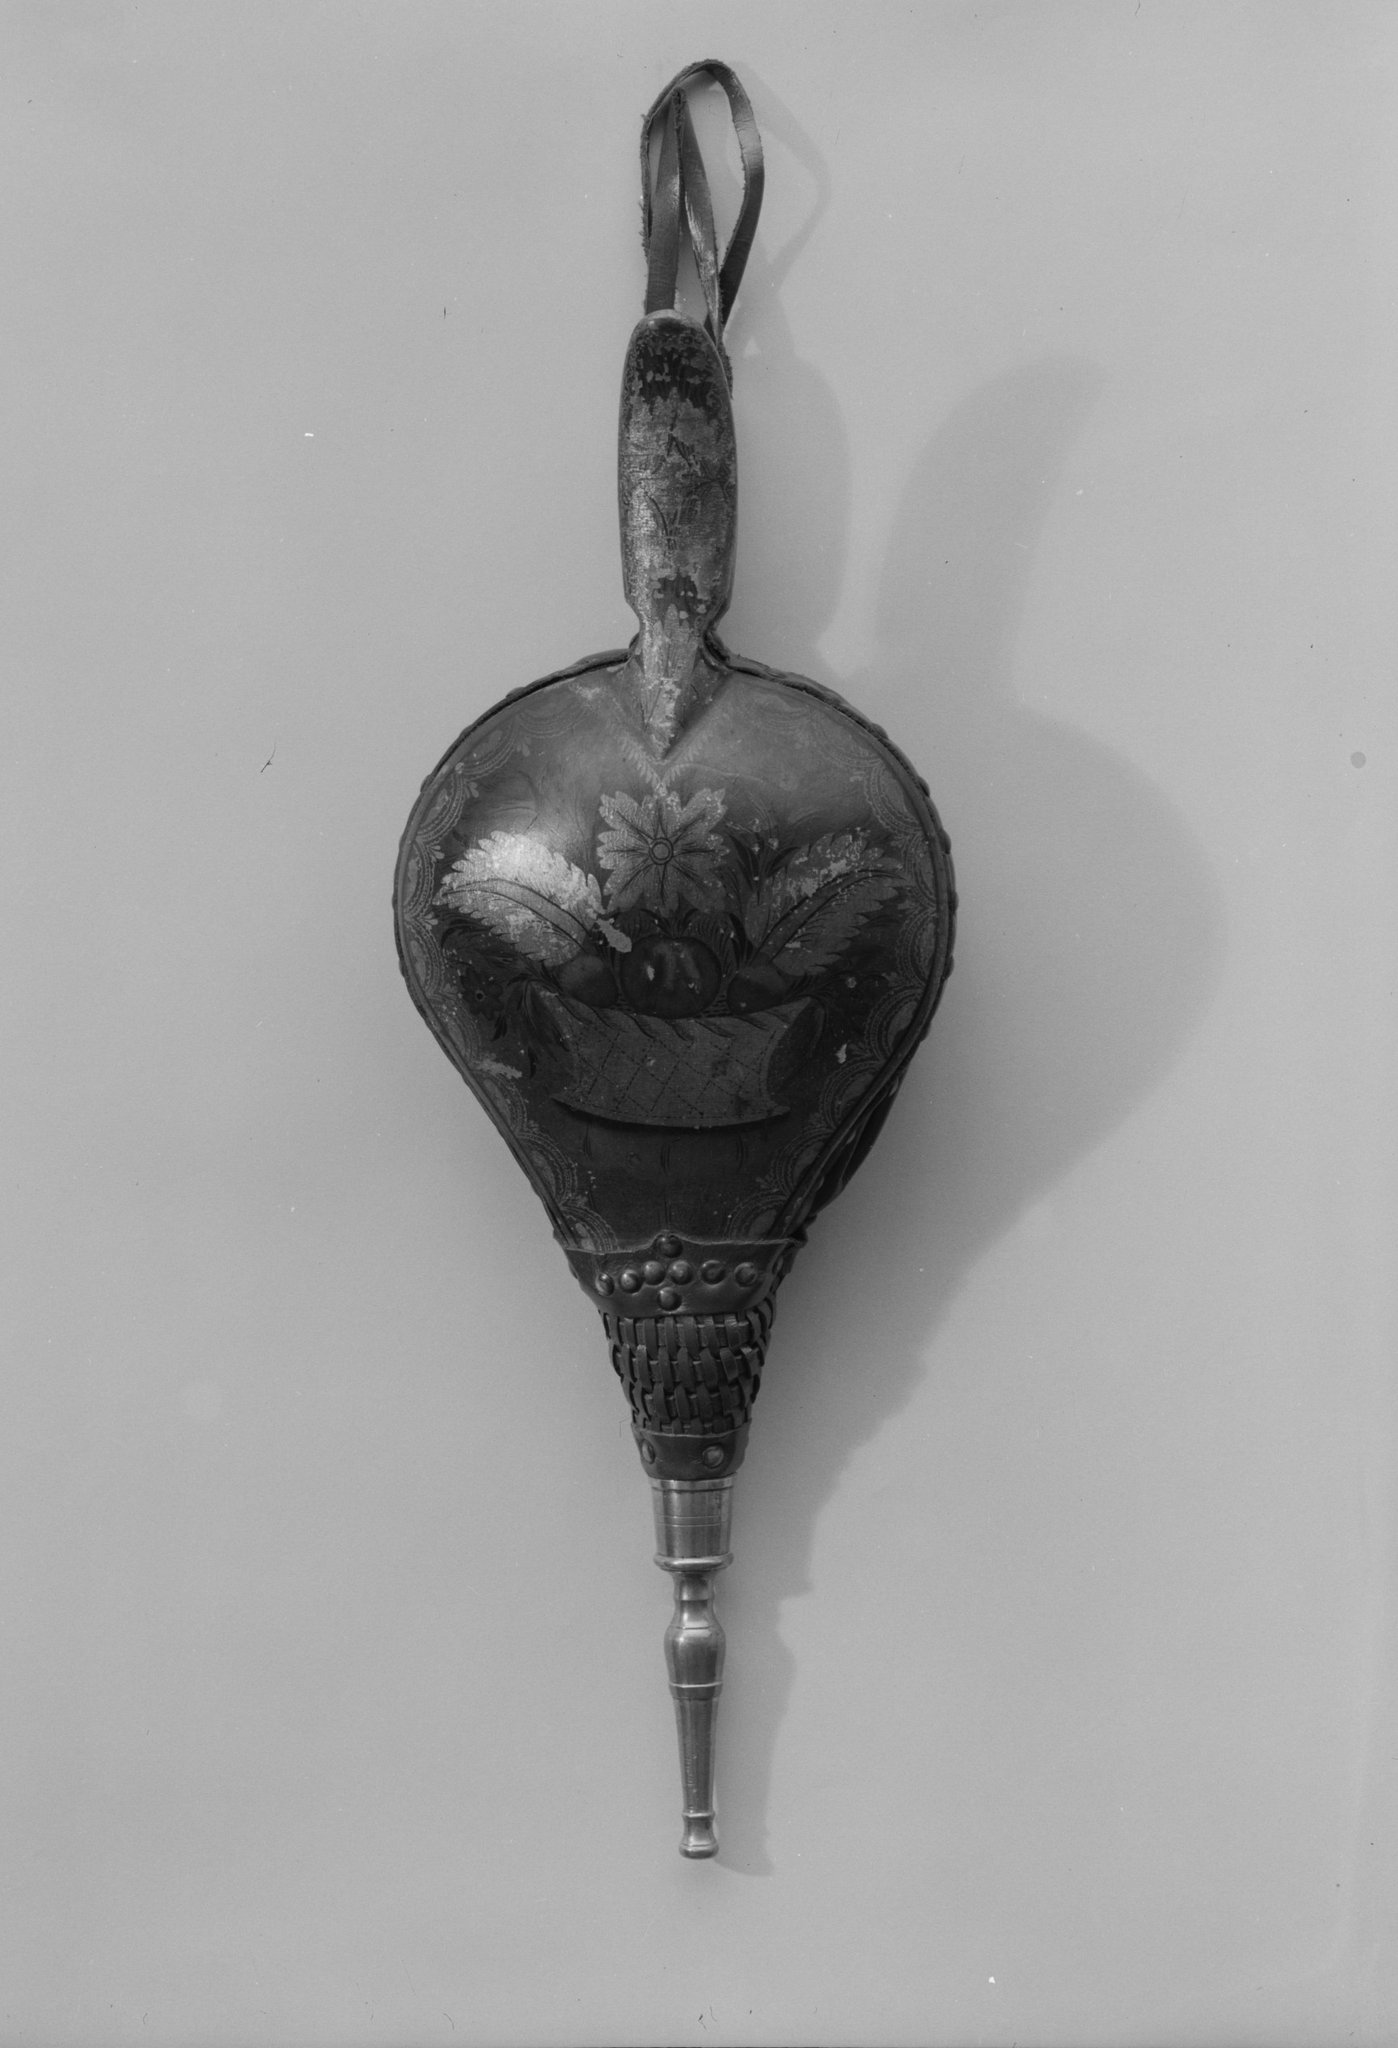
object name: bellow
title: Bellows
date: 1810-1820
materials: brass, leather, wood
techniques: lacquer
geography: united states